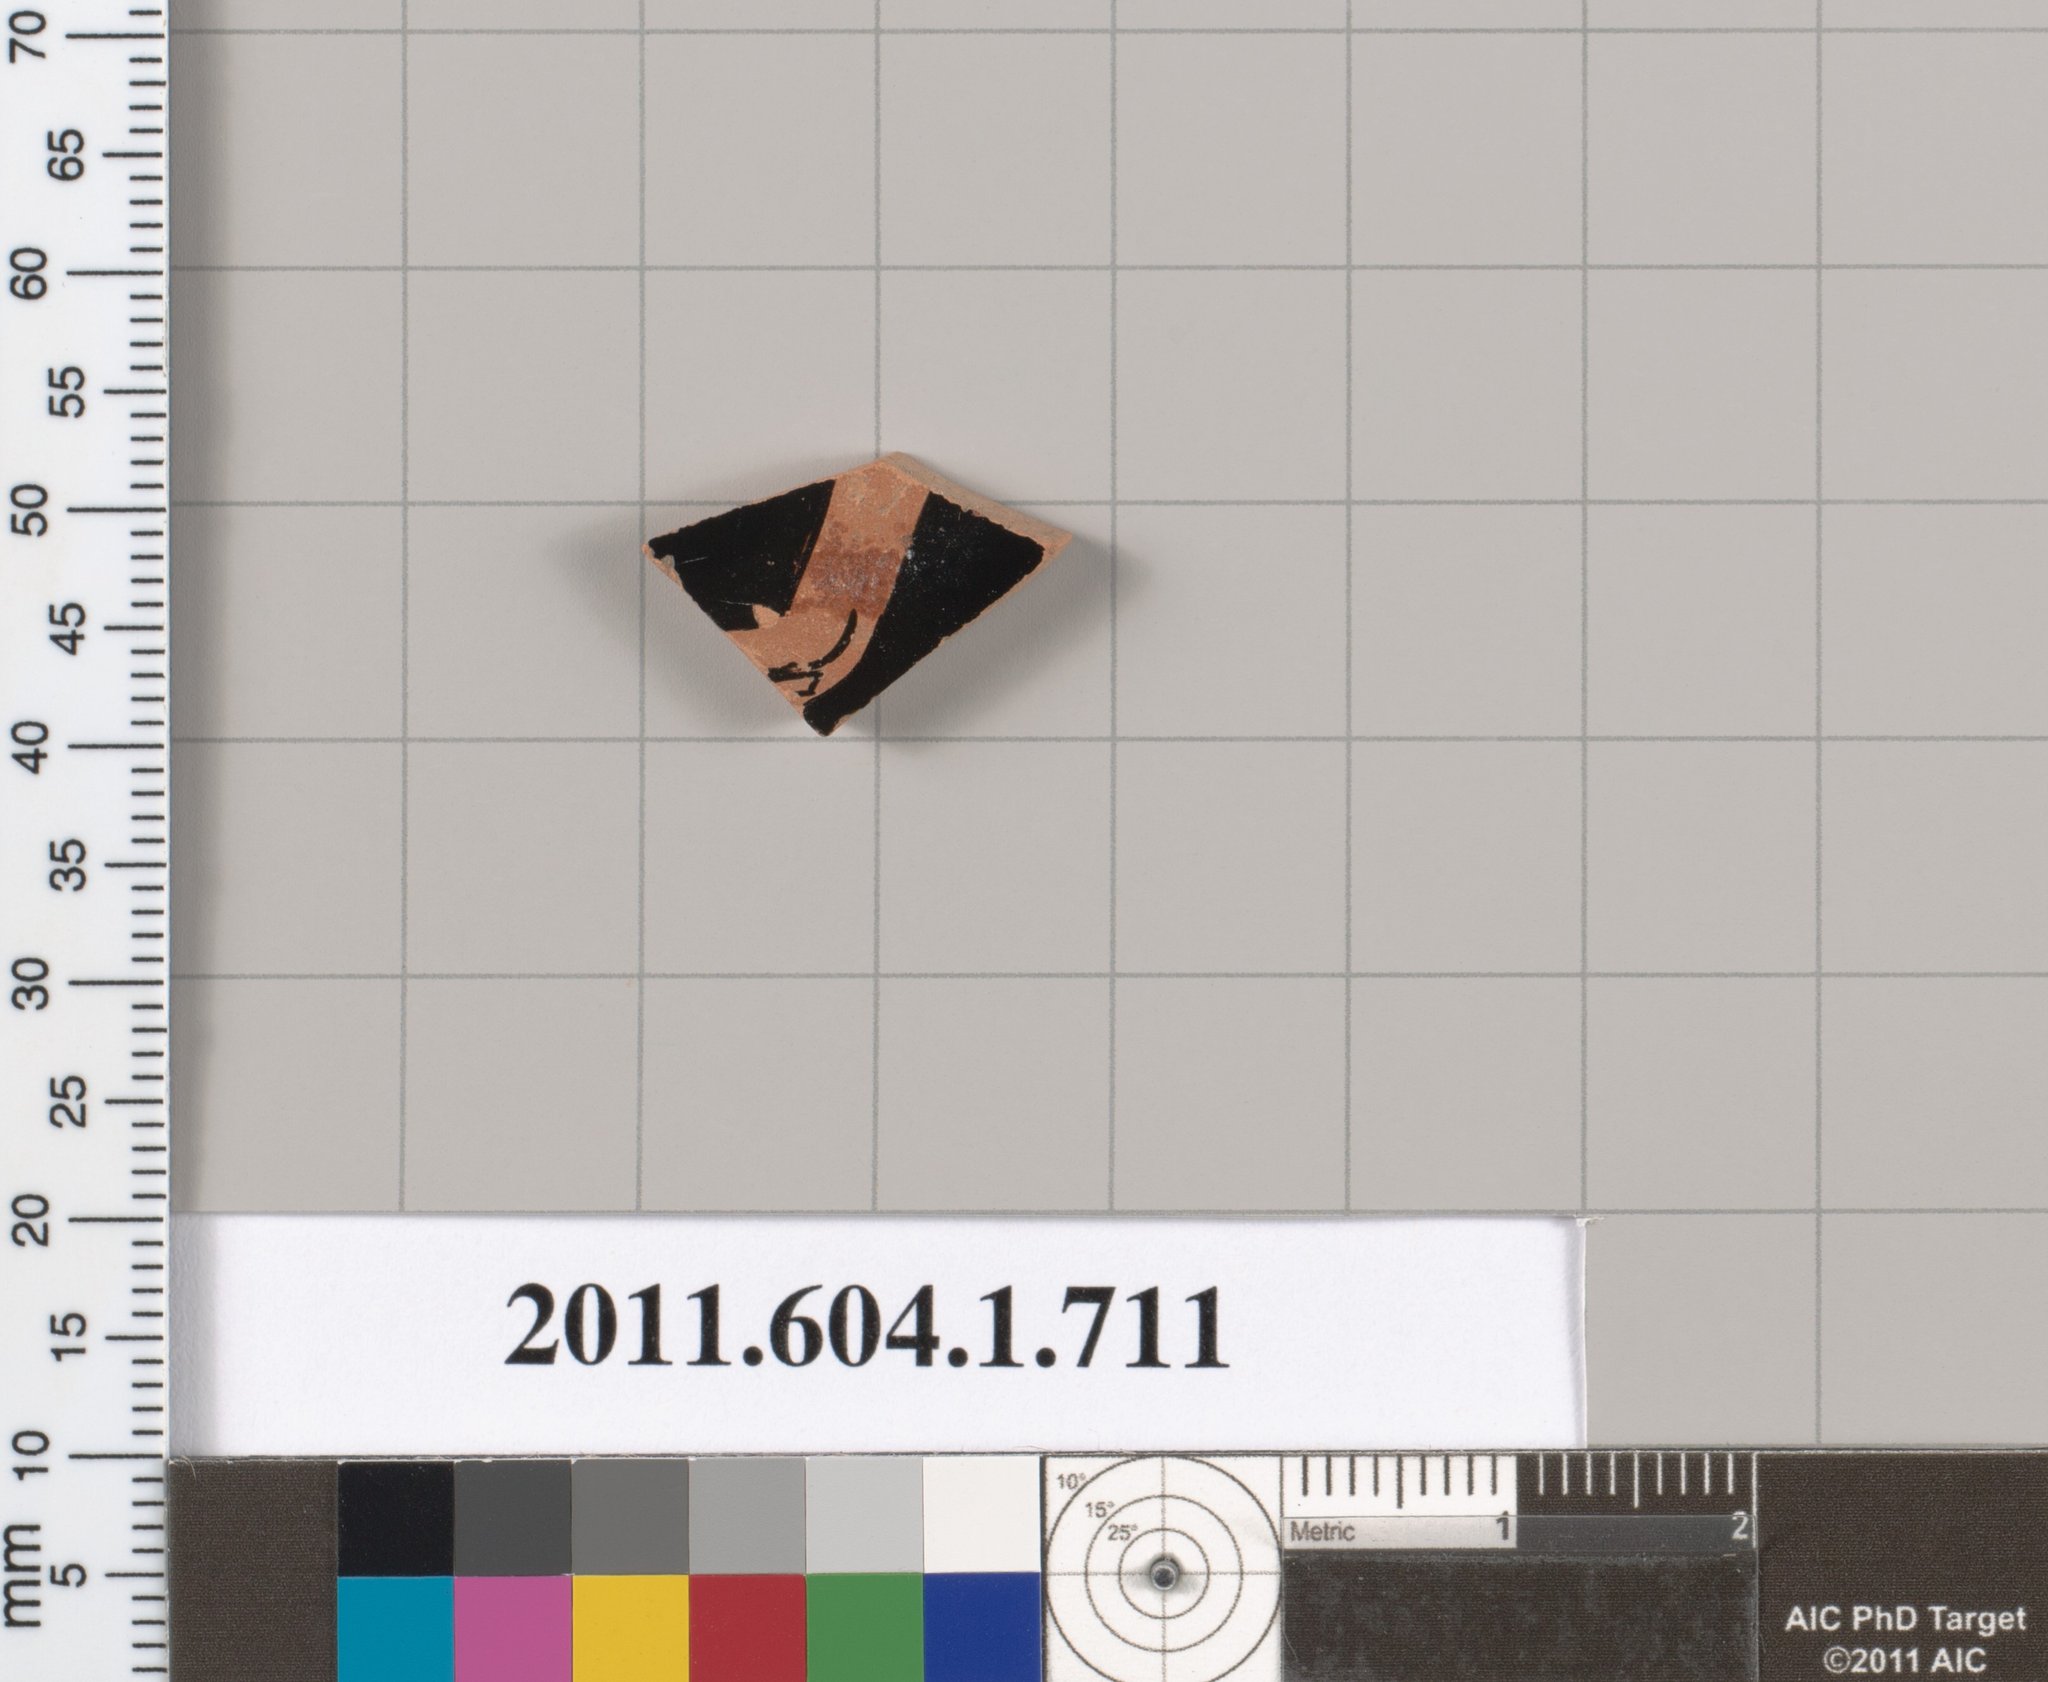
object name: kylix fragment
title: Terracotta fragment of a kylix (drinking cup)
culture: greek, attic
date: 475-451 BCE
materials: terracotta